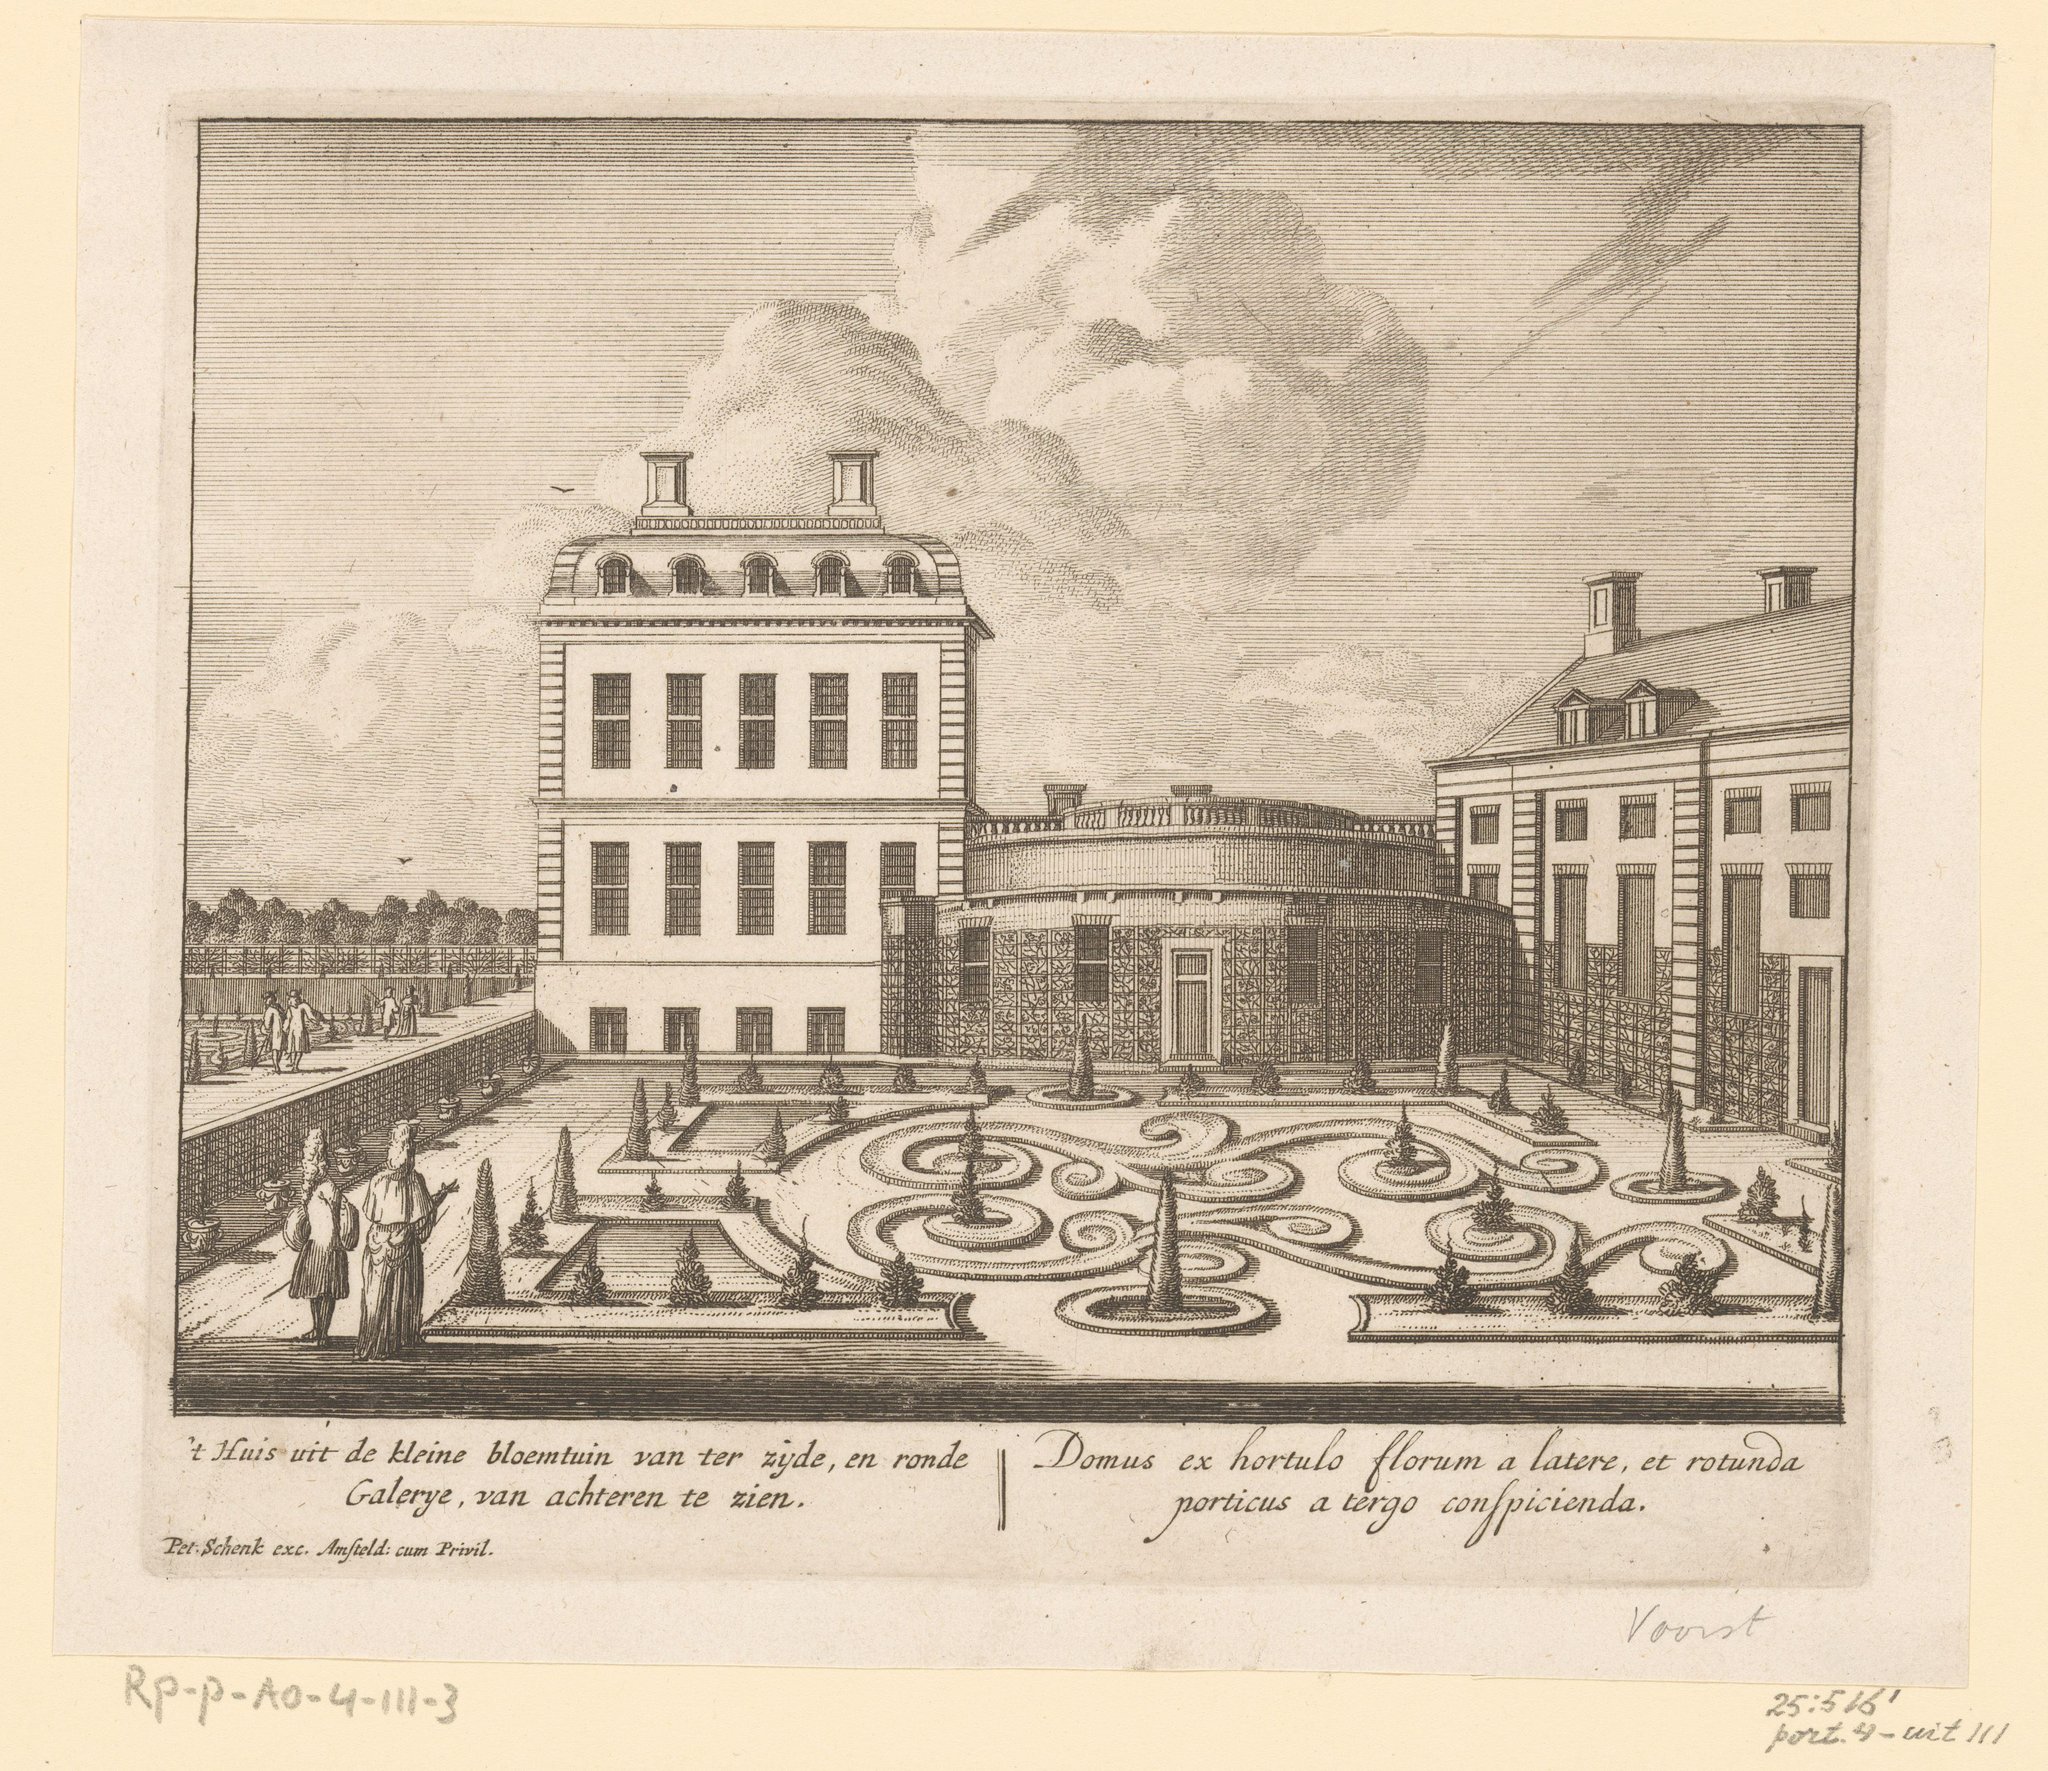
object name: print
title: 't Huis uit de kleine bloementuin van ter zijde, en ronde galerye, van achteren te zien / Domus ex hortulo florum a latere, et rotunda porticus a tergo conspicienda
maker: pieter schenk (i)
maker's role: print maker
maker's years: 1660-1711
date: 1700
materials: paper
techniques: engraving, etching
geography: amsterdam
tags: palace, french or architectonic garden; formal garden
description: Prent is uitgeven door Pieter Schenk (I) als onderdeel van de zestiendelige prentserie 'Praetorium Dieranum', ca. 1700. Later is de prent ook gebruikt in: Schenk, Pieter (I). Paradisus Oculorum: sive conspectus degantissimi centum (...). Jacobus Romanus, ca. 1700.